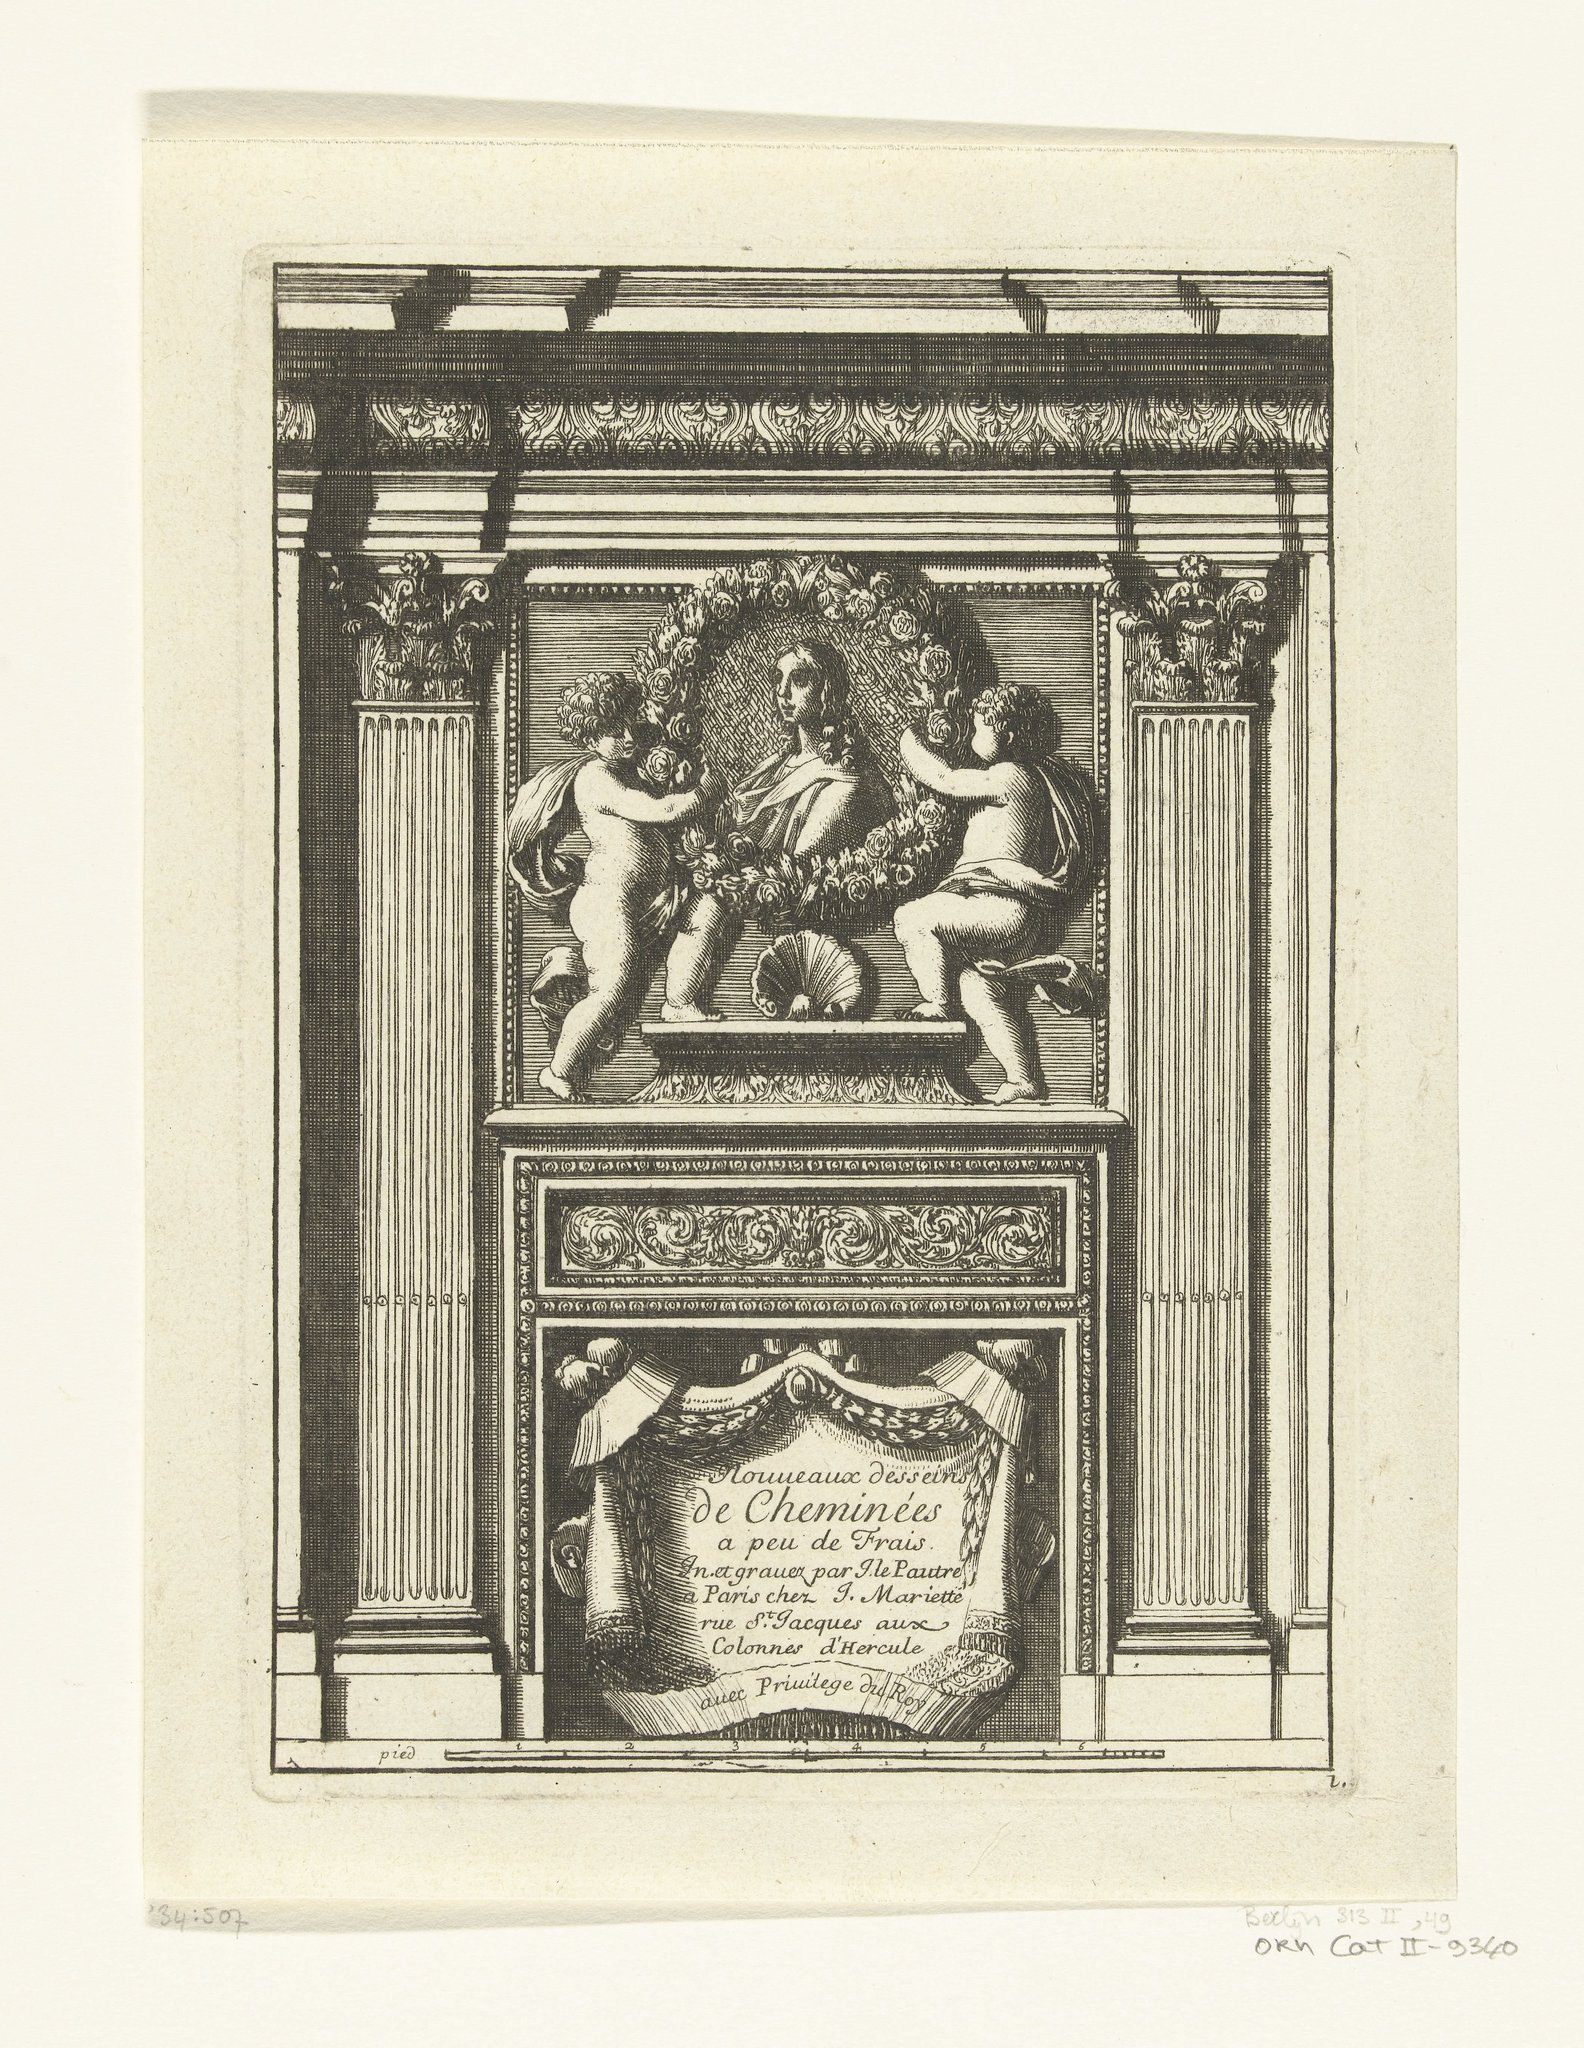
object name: ornament print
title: Titelblad: Nouueaux desseins de Cheminées a peu de Frais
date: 1710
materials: paper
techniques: etching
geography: paris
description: Onderboezem. Op de architraaf staat een voetstuk met twee putti die een bloemenkrans omhooghouden met het portret van een jongeman erin. Uit tweede editie.